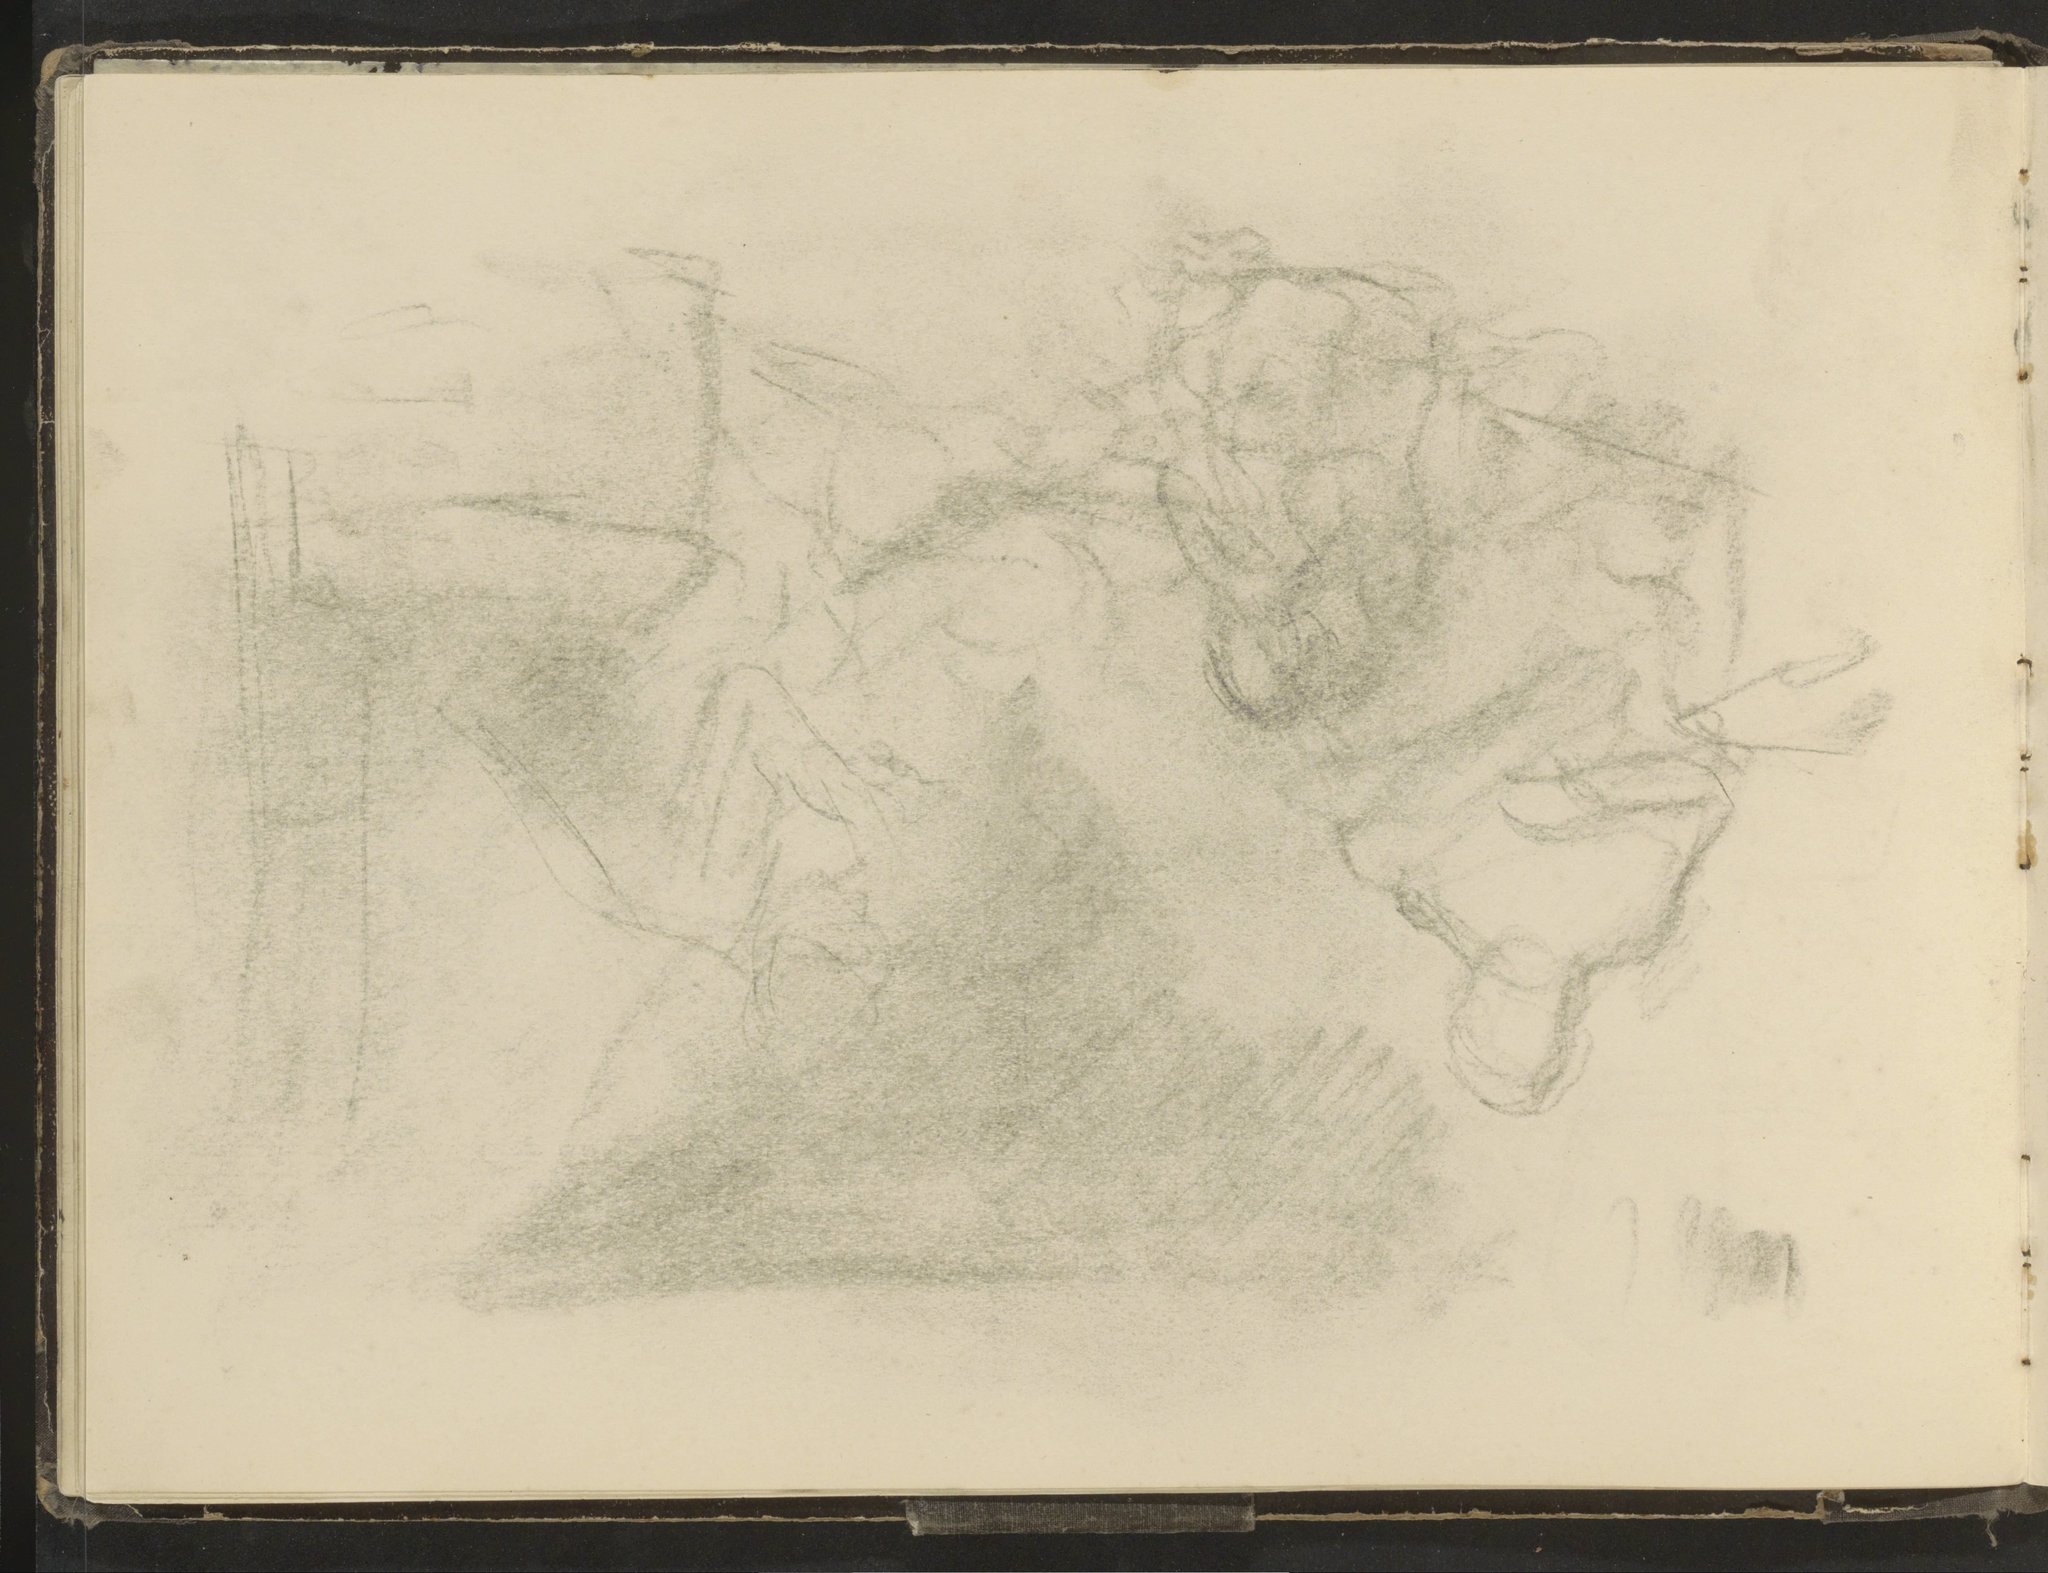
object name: sketchbook leaf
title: Interieur met twee zittende vrouwen en kinderen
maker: albert neuhuys (1844-1914)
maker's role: draughtsman, painter, print maker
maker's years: 1844-1914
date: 1854-1914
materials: charcoal, paper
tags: sitting figure, adult woman, interior of the house, infant, baby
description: Vermoedelijk heeft één van de vrouwen een baby op schoot. Blad 8 verso uit een schetsboek met 43 bladen.